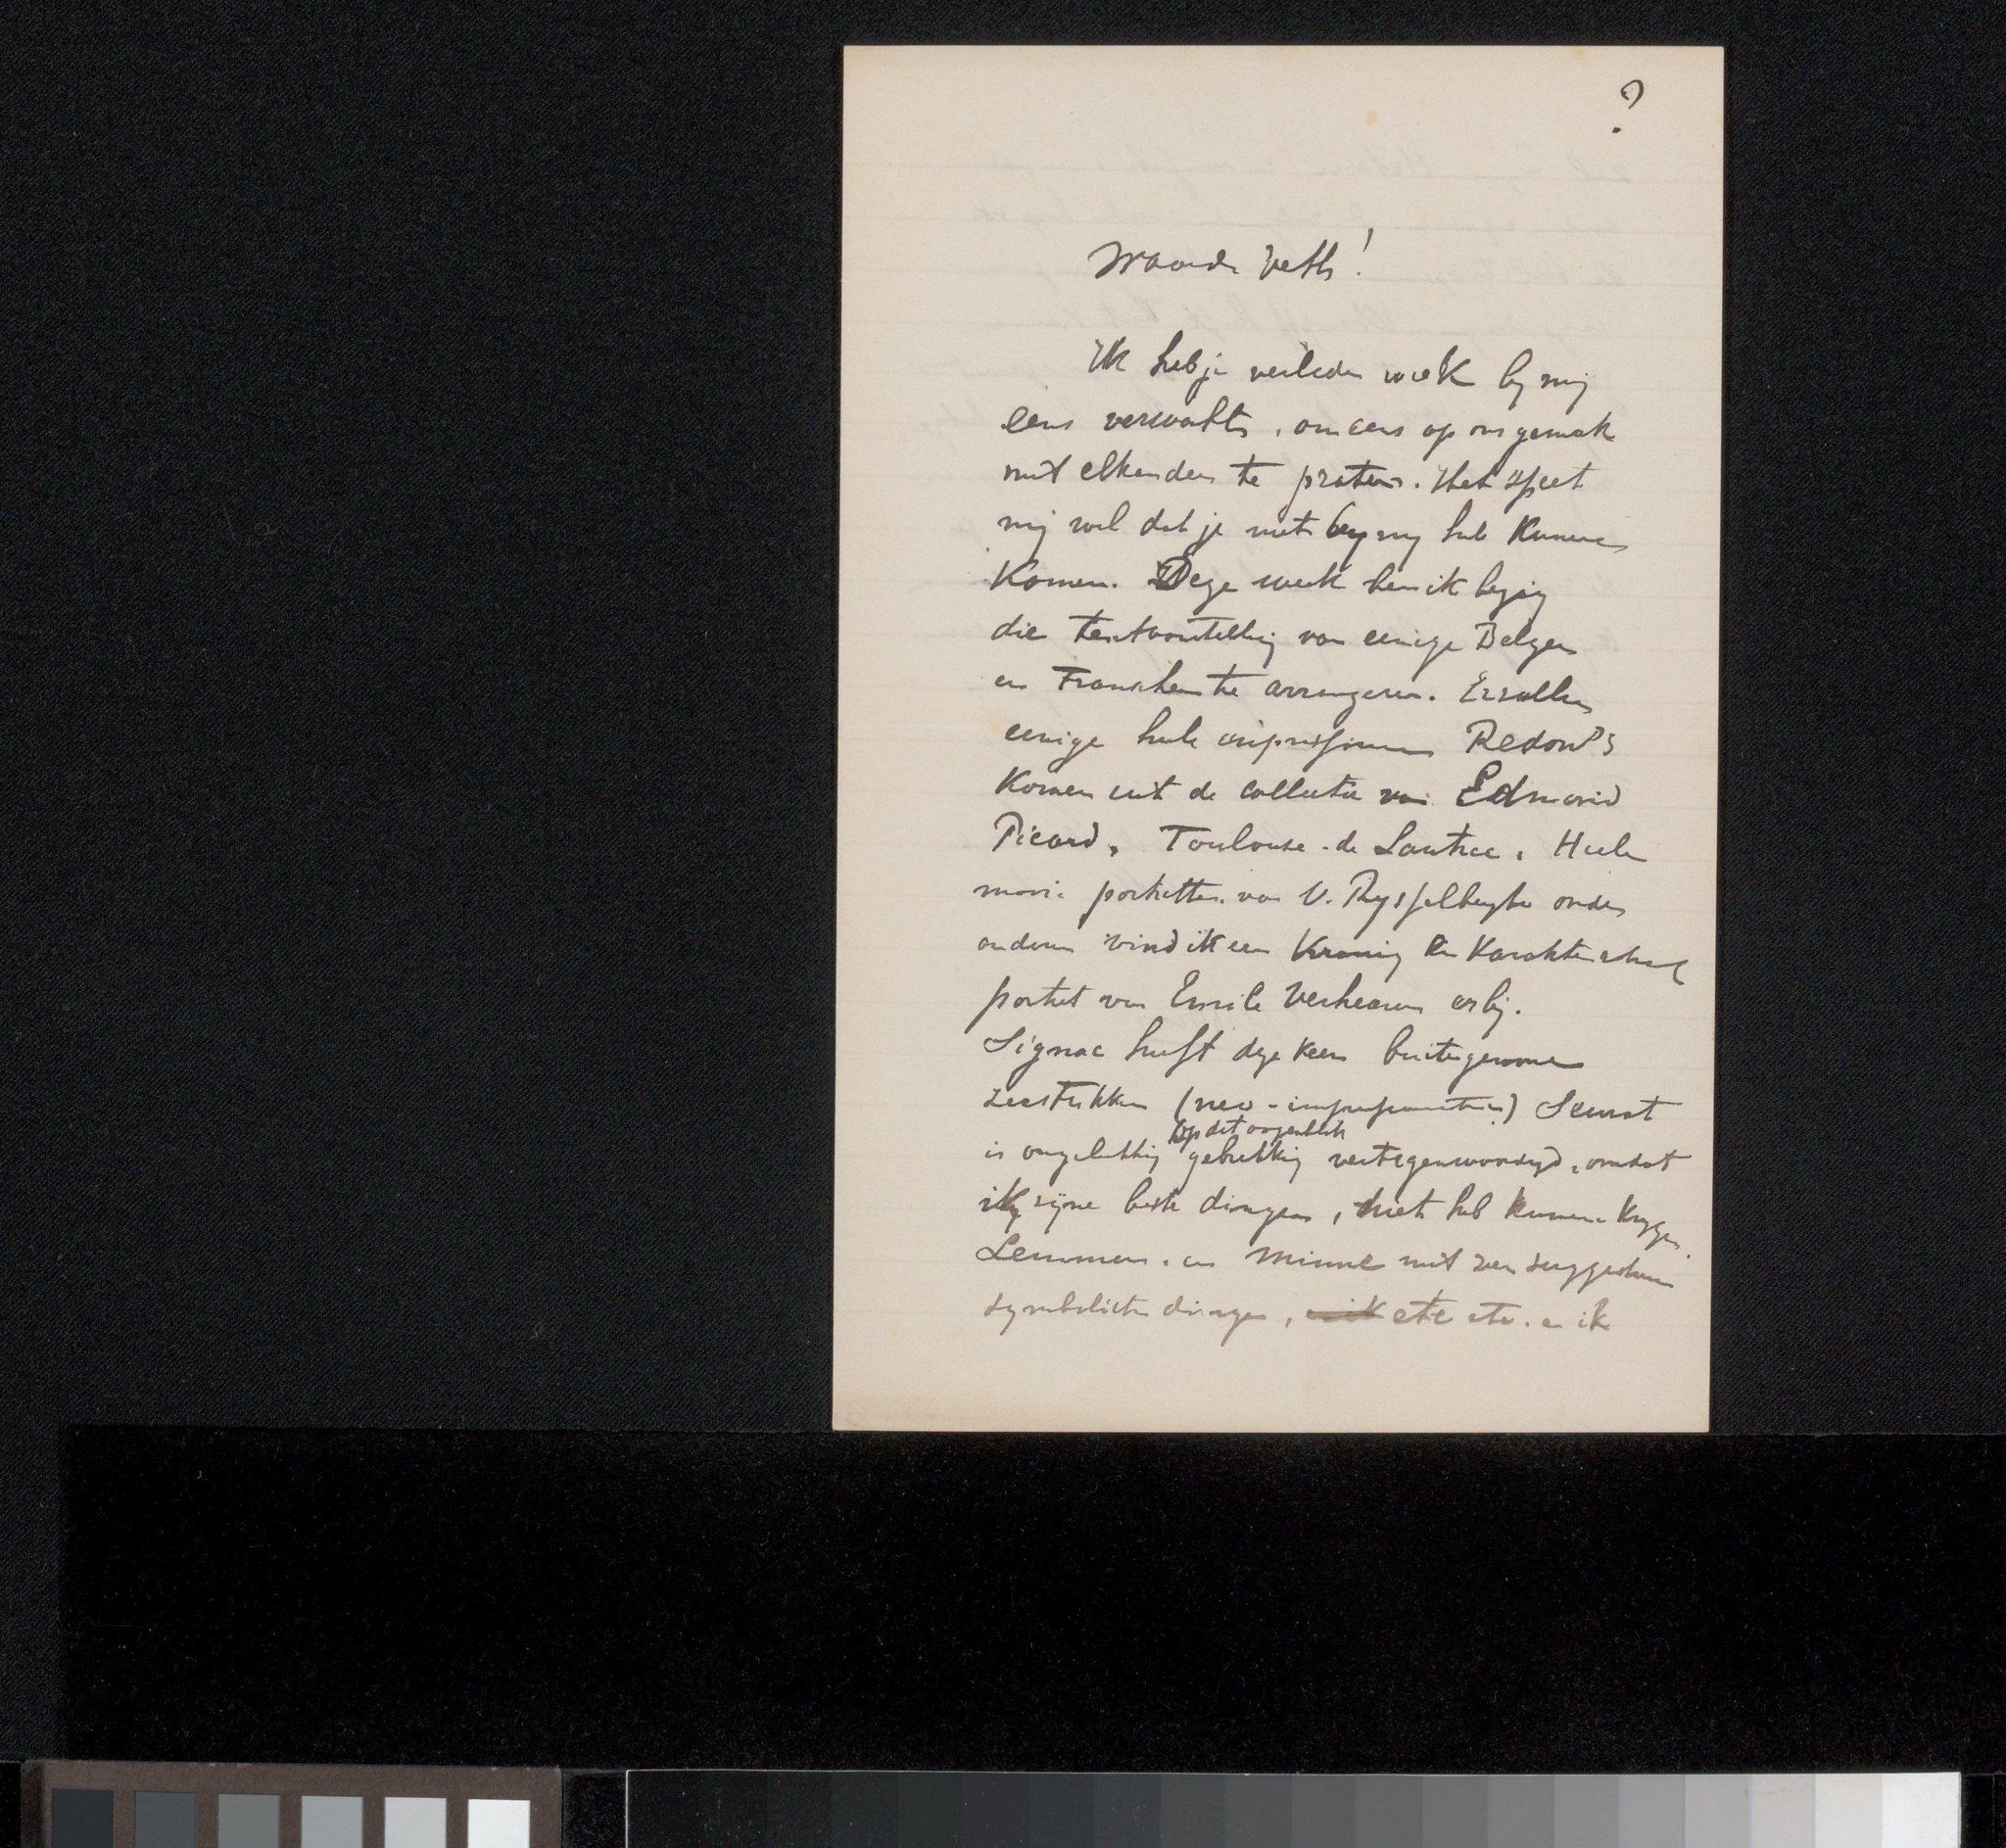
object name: letter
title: Brief aan Jan Veth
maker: jan toorop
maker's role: draughtsman, painter, print maker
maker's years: 1858-1928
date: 1874-1925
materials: ink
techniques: pen, writing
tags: paris, odilon redon, fernand khnopff, dordrecht, painter, print maker, draughtsman, designer, jan veth, ghent, theo van rysselberghe, paul signac, henri de toulouse-lautrec, george minne, emile verhaeren, brussels, edmond picard, the graphic arts, exhibition ~ art, art collecting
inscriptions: collector's mark: ‘RPK’